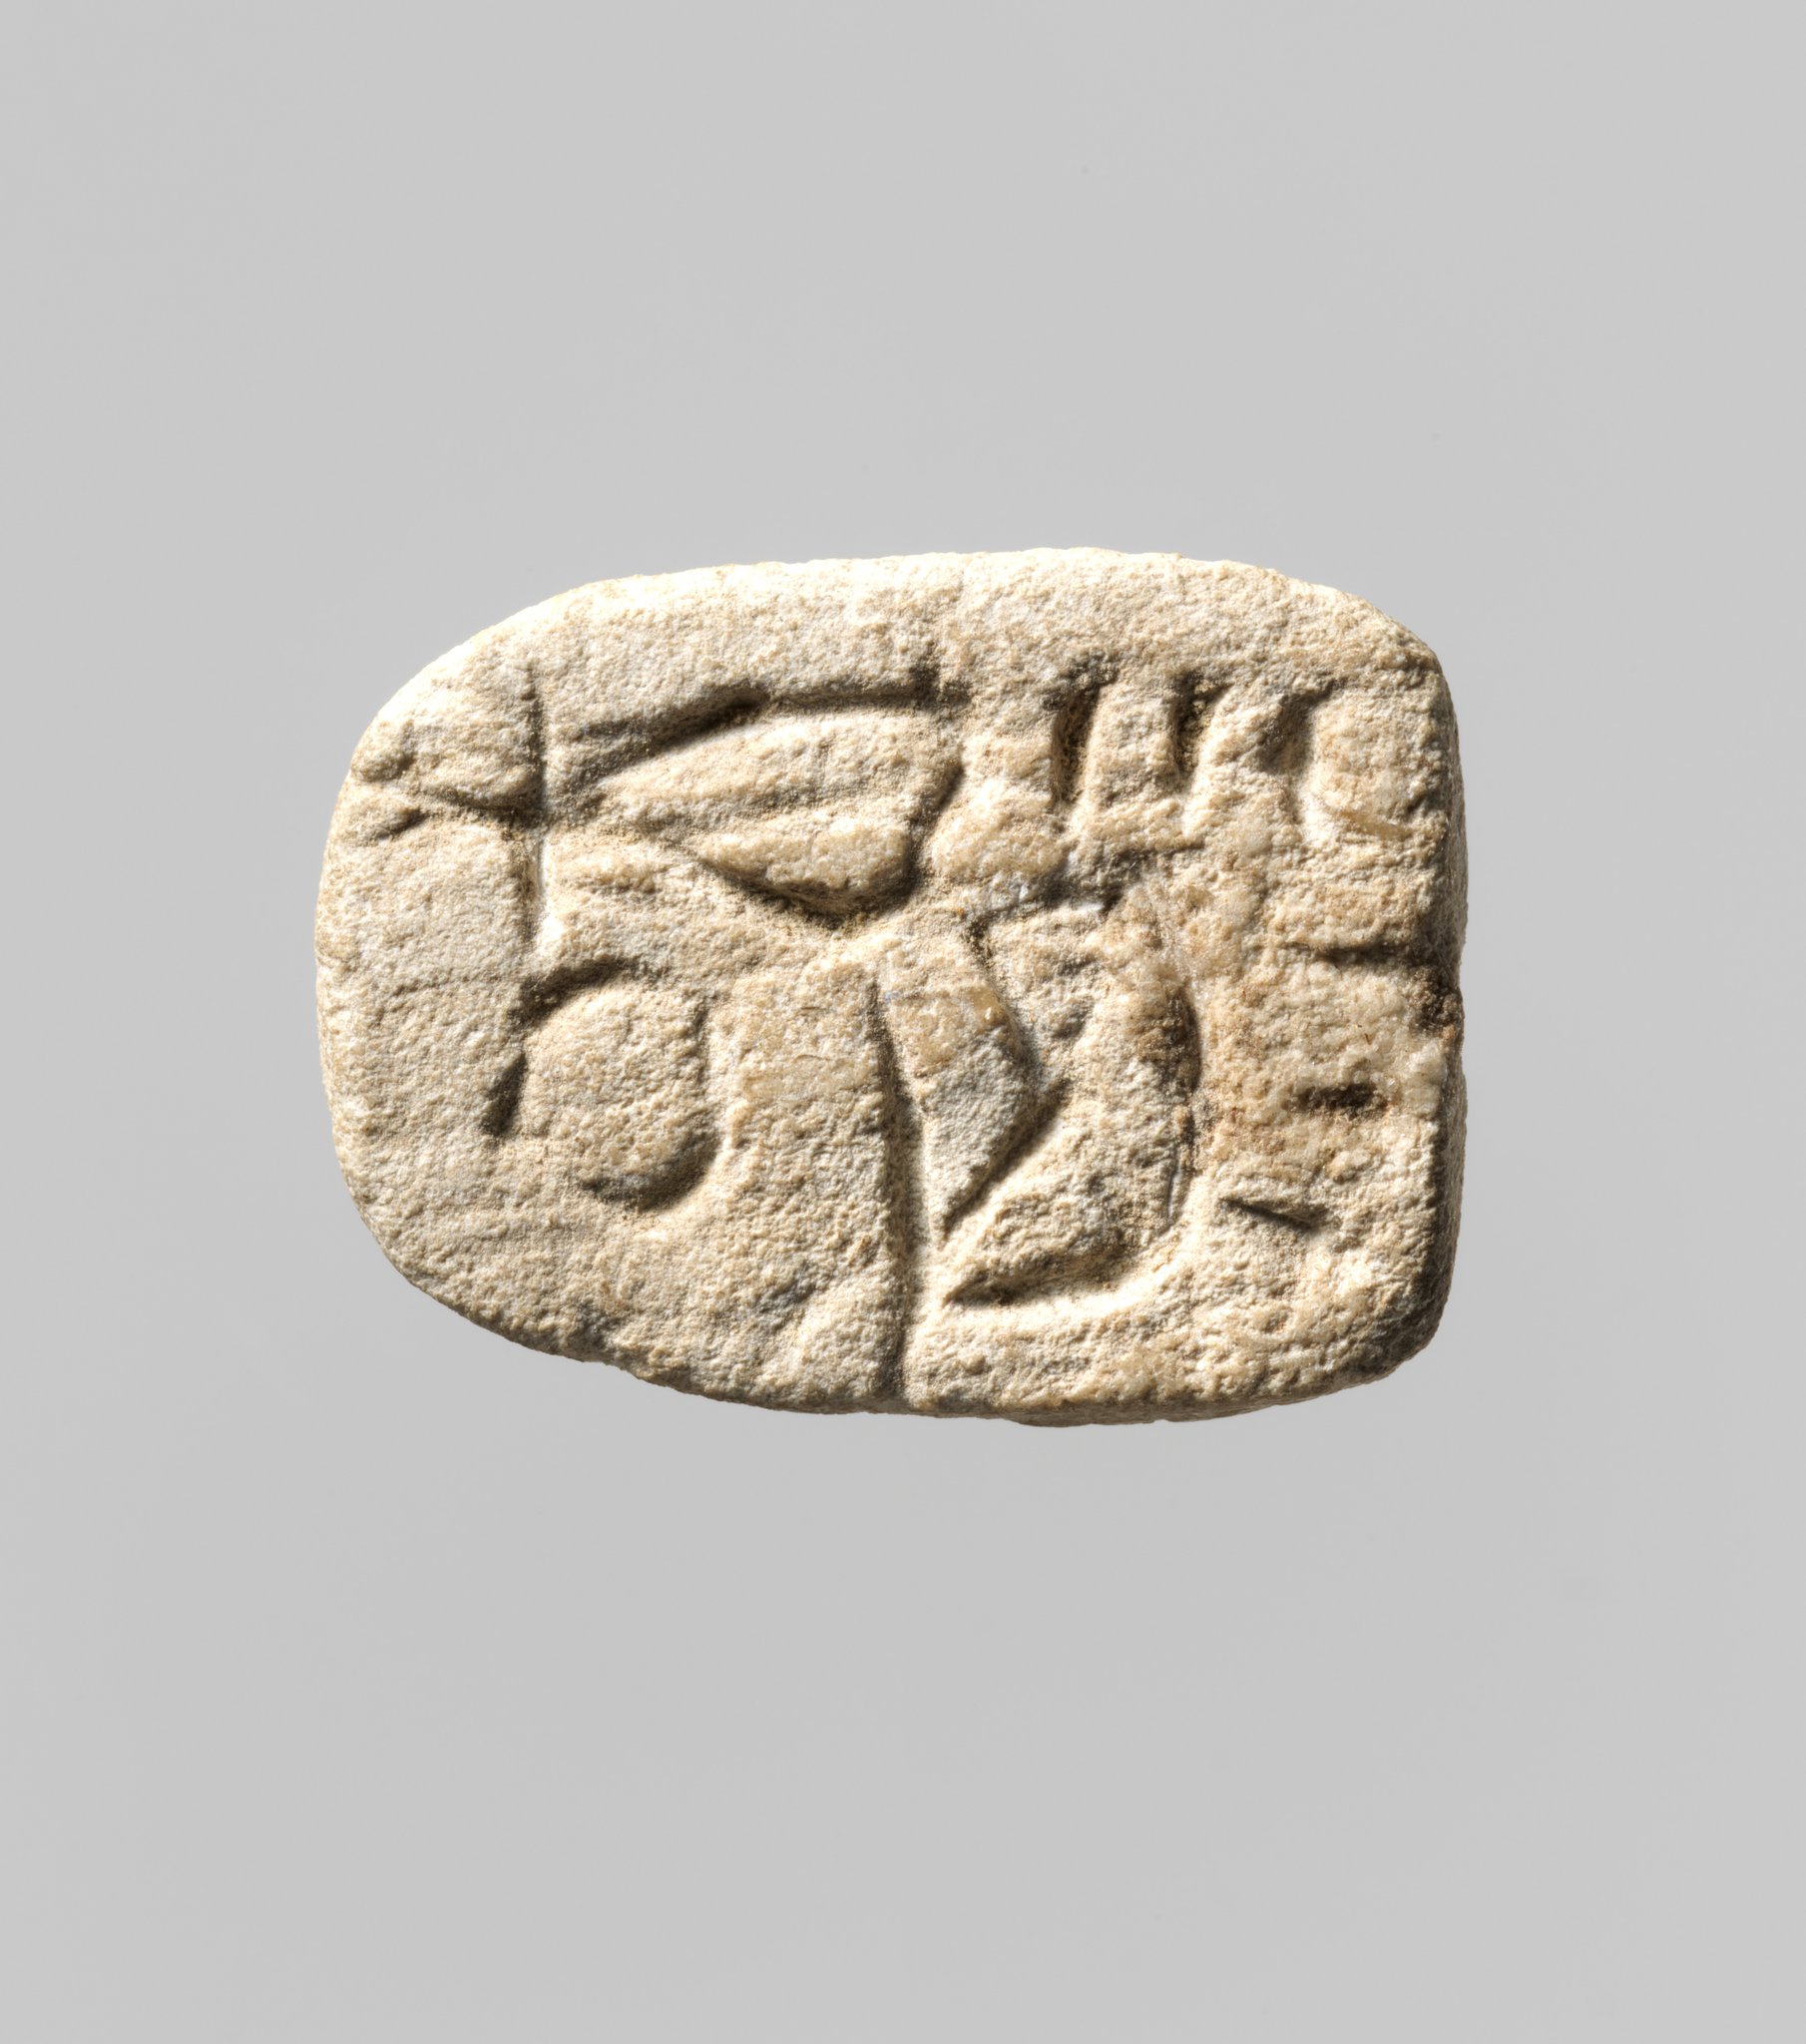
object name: stamp, plaque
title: Stamp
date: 1295-1070 BCE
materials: limestone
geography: egypt